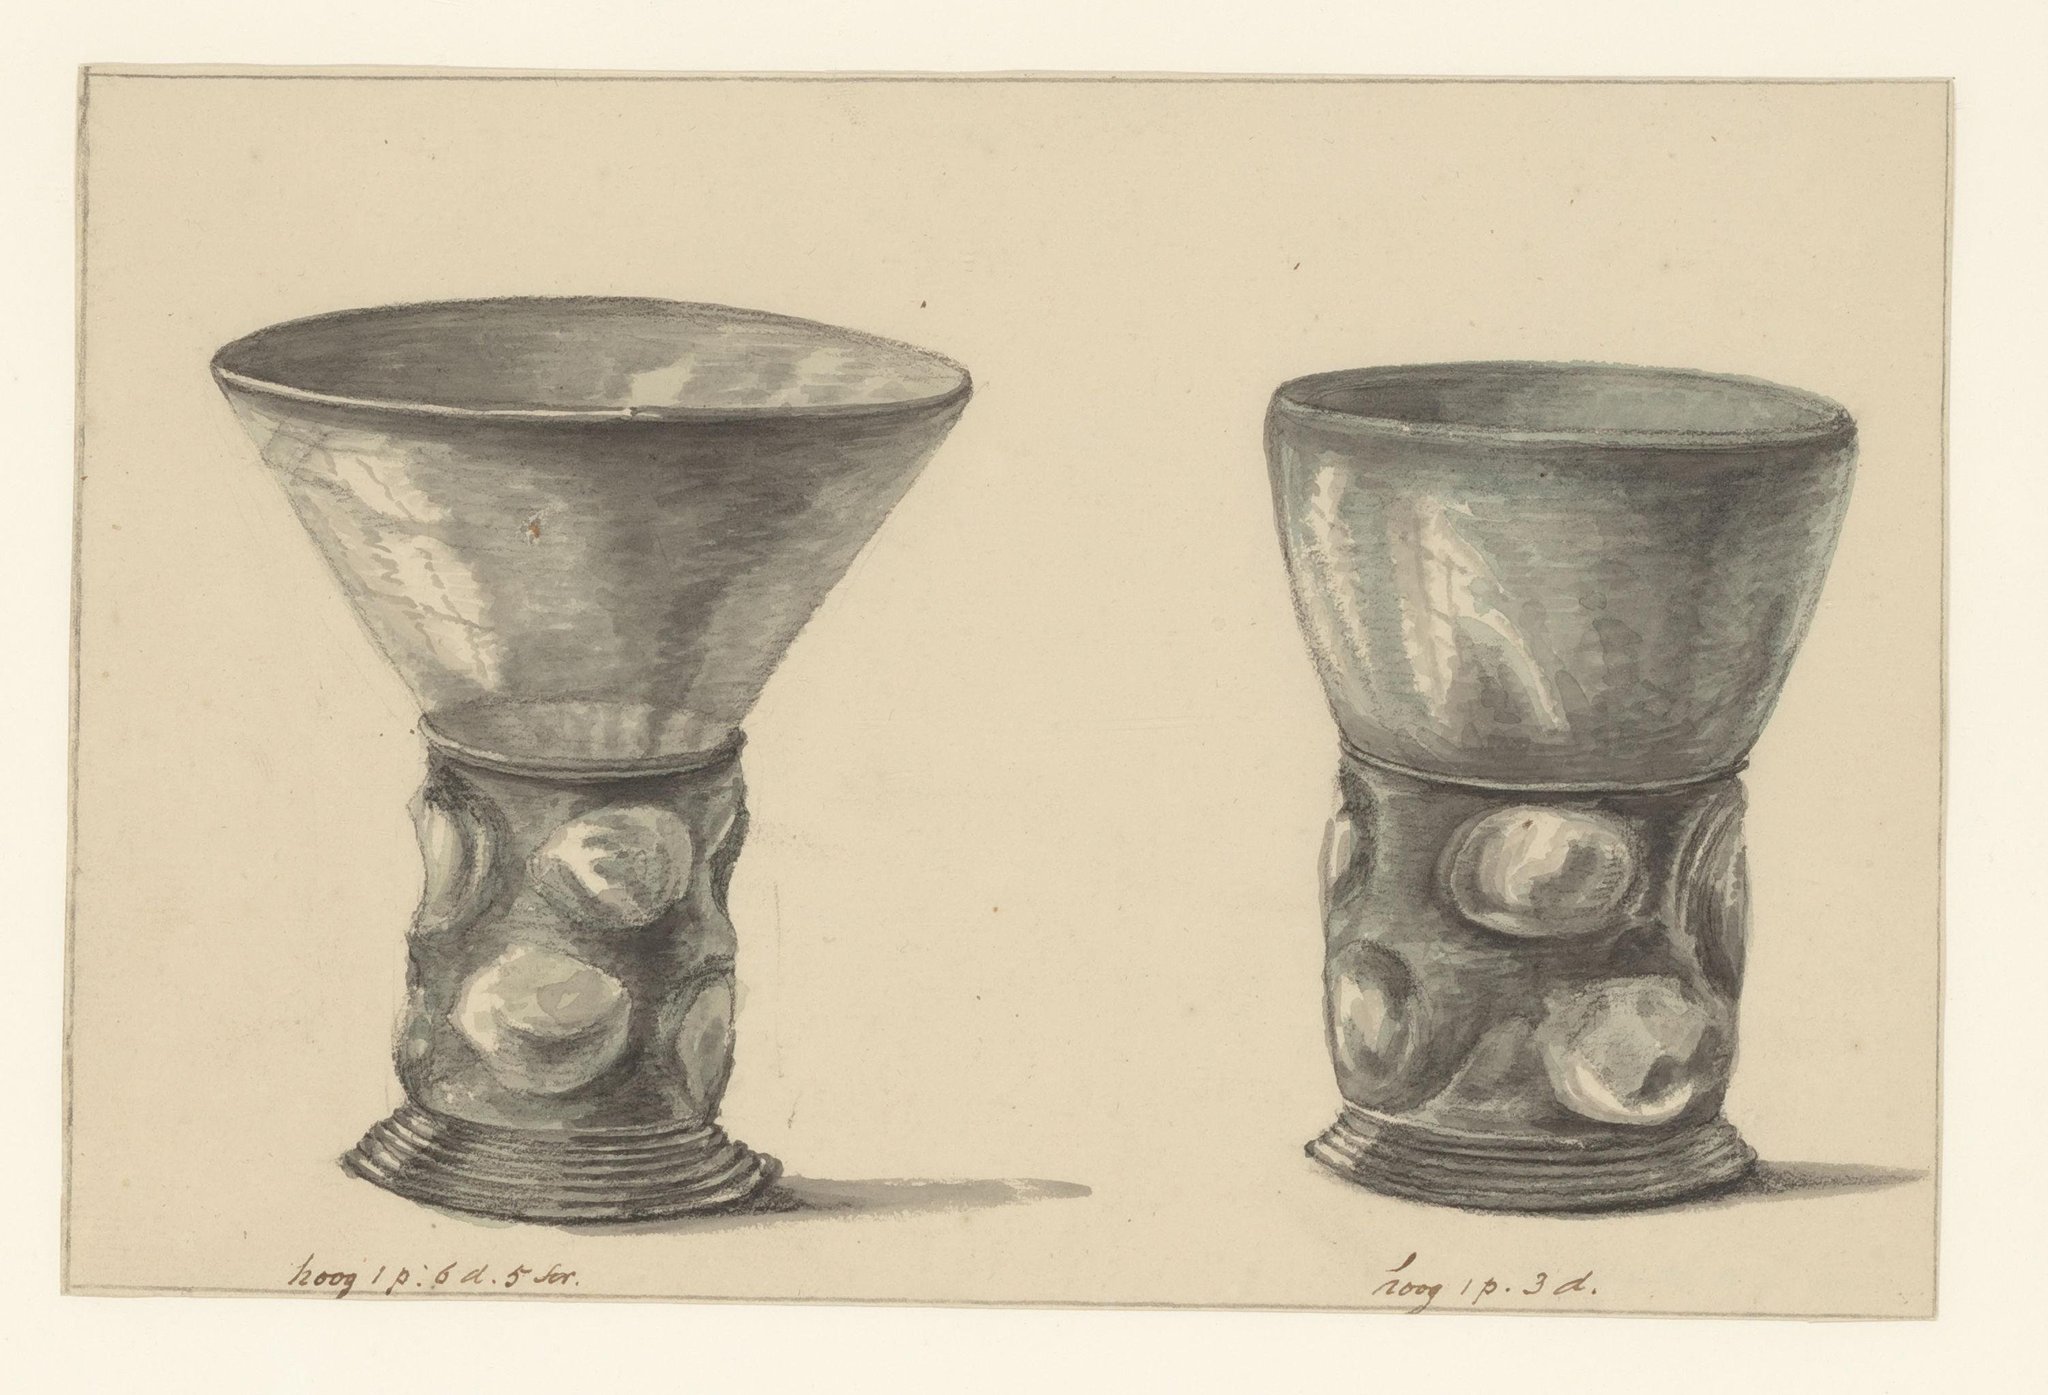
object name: drawing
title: Twee wijnglazen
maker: gerrit lamberts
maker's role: bookseller, draughtsman, print maker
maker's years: 1776-1850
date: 1790-1850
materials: chalk, ink, paper, pencil, watercolor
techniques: brush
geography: netherlands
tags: glass, rummer, alcoholic drinks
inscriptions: collector's mark: Lugt 1641, collector's mark